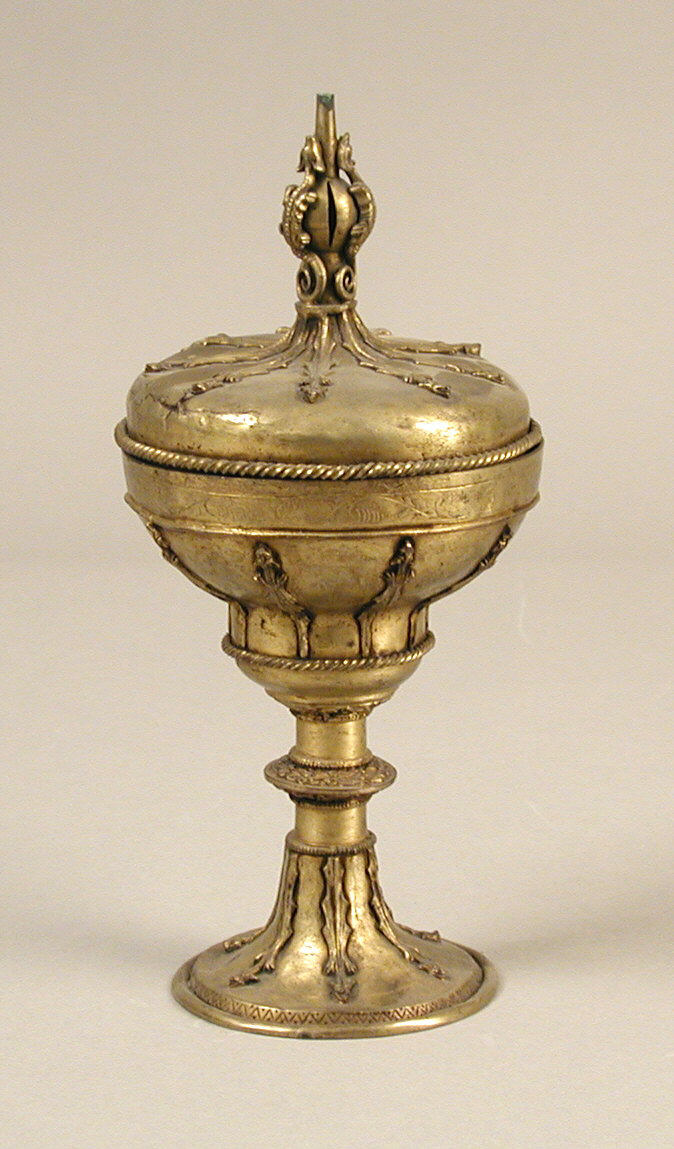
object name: cup with cover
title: Cup and Cover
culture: hungarian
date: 1901-1933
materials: silver gilt